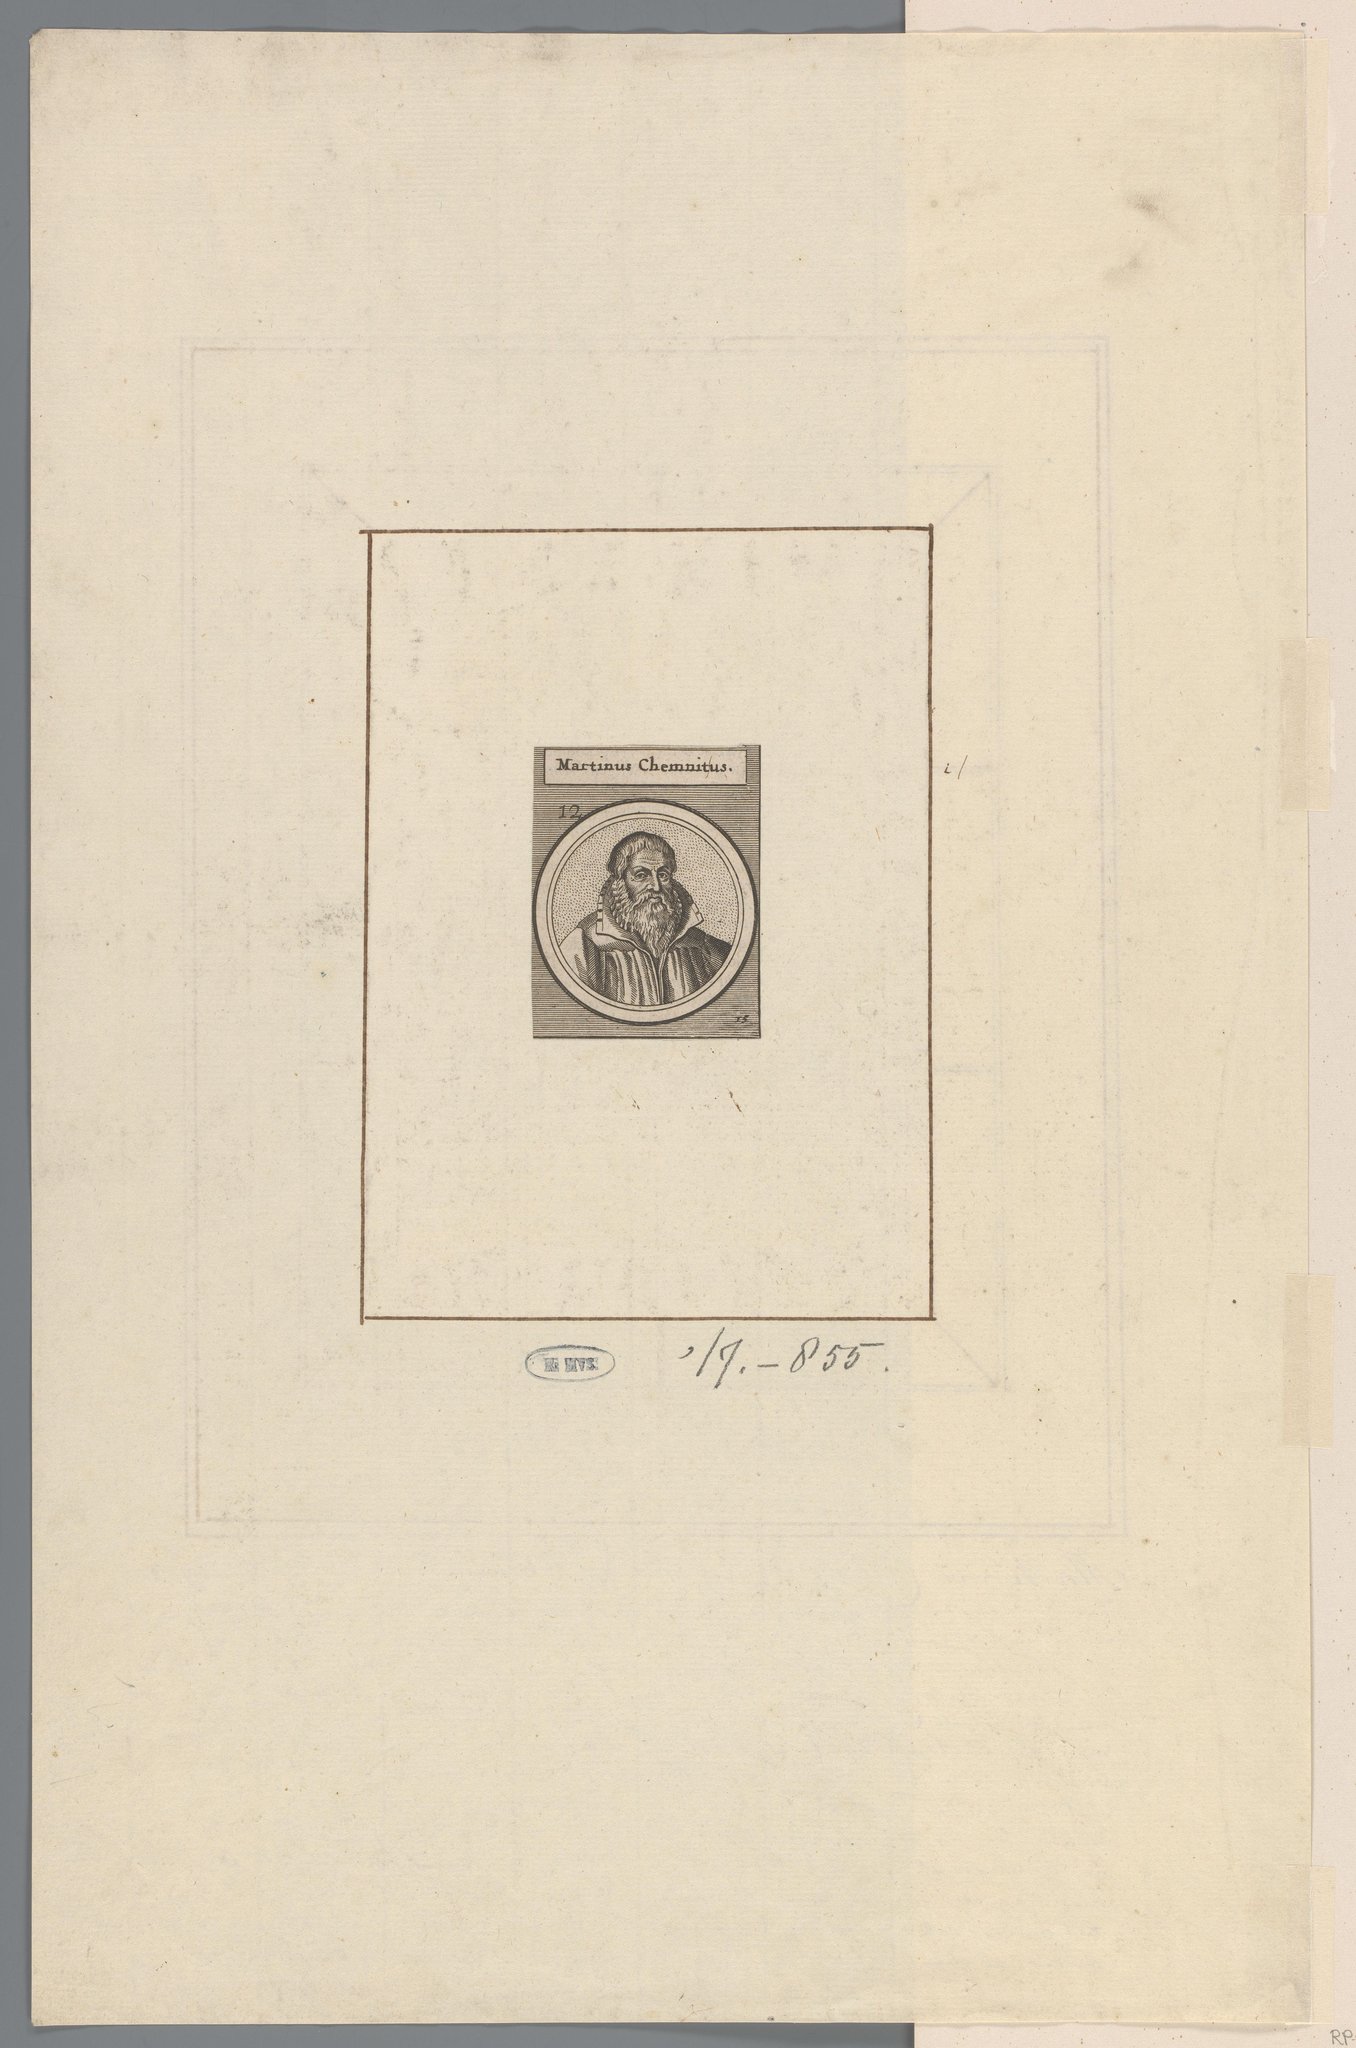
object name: print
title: Portret van Martinus Chemnitz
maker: pieter van der aa (i)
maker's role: printer, publisher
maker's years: 1659-1733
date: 1698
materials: paper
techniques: engraving, etching, letterpress printing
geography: leiden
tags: historical persons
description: De prent maakt onderdeel uit van een grotere plaat met 24 portretten. Prent uit: Gottfried, Johan Ludwig en Simon de Vries. Historische kronyck: vervattende een nauwkeurige en volkomene beschrijvingh der aldergedenck waerdiste geschiedenissen des weerelds (...). Leiden: weduwe Joannes Brouwer en Jacobus van Meurs, 1660, dl. 2. Prent ook gebruikt in latere edities.